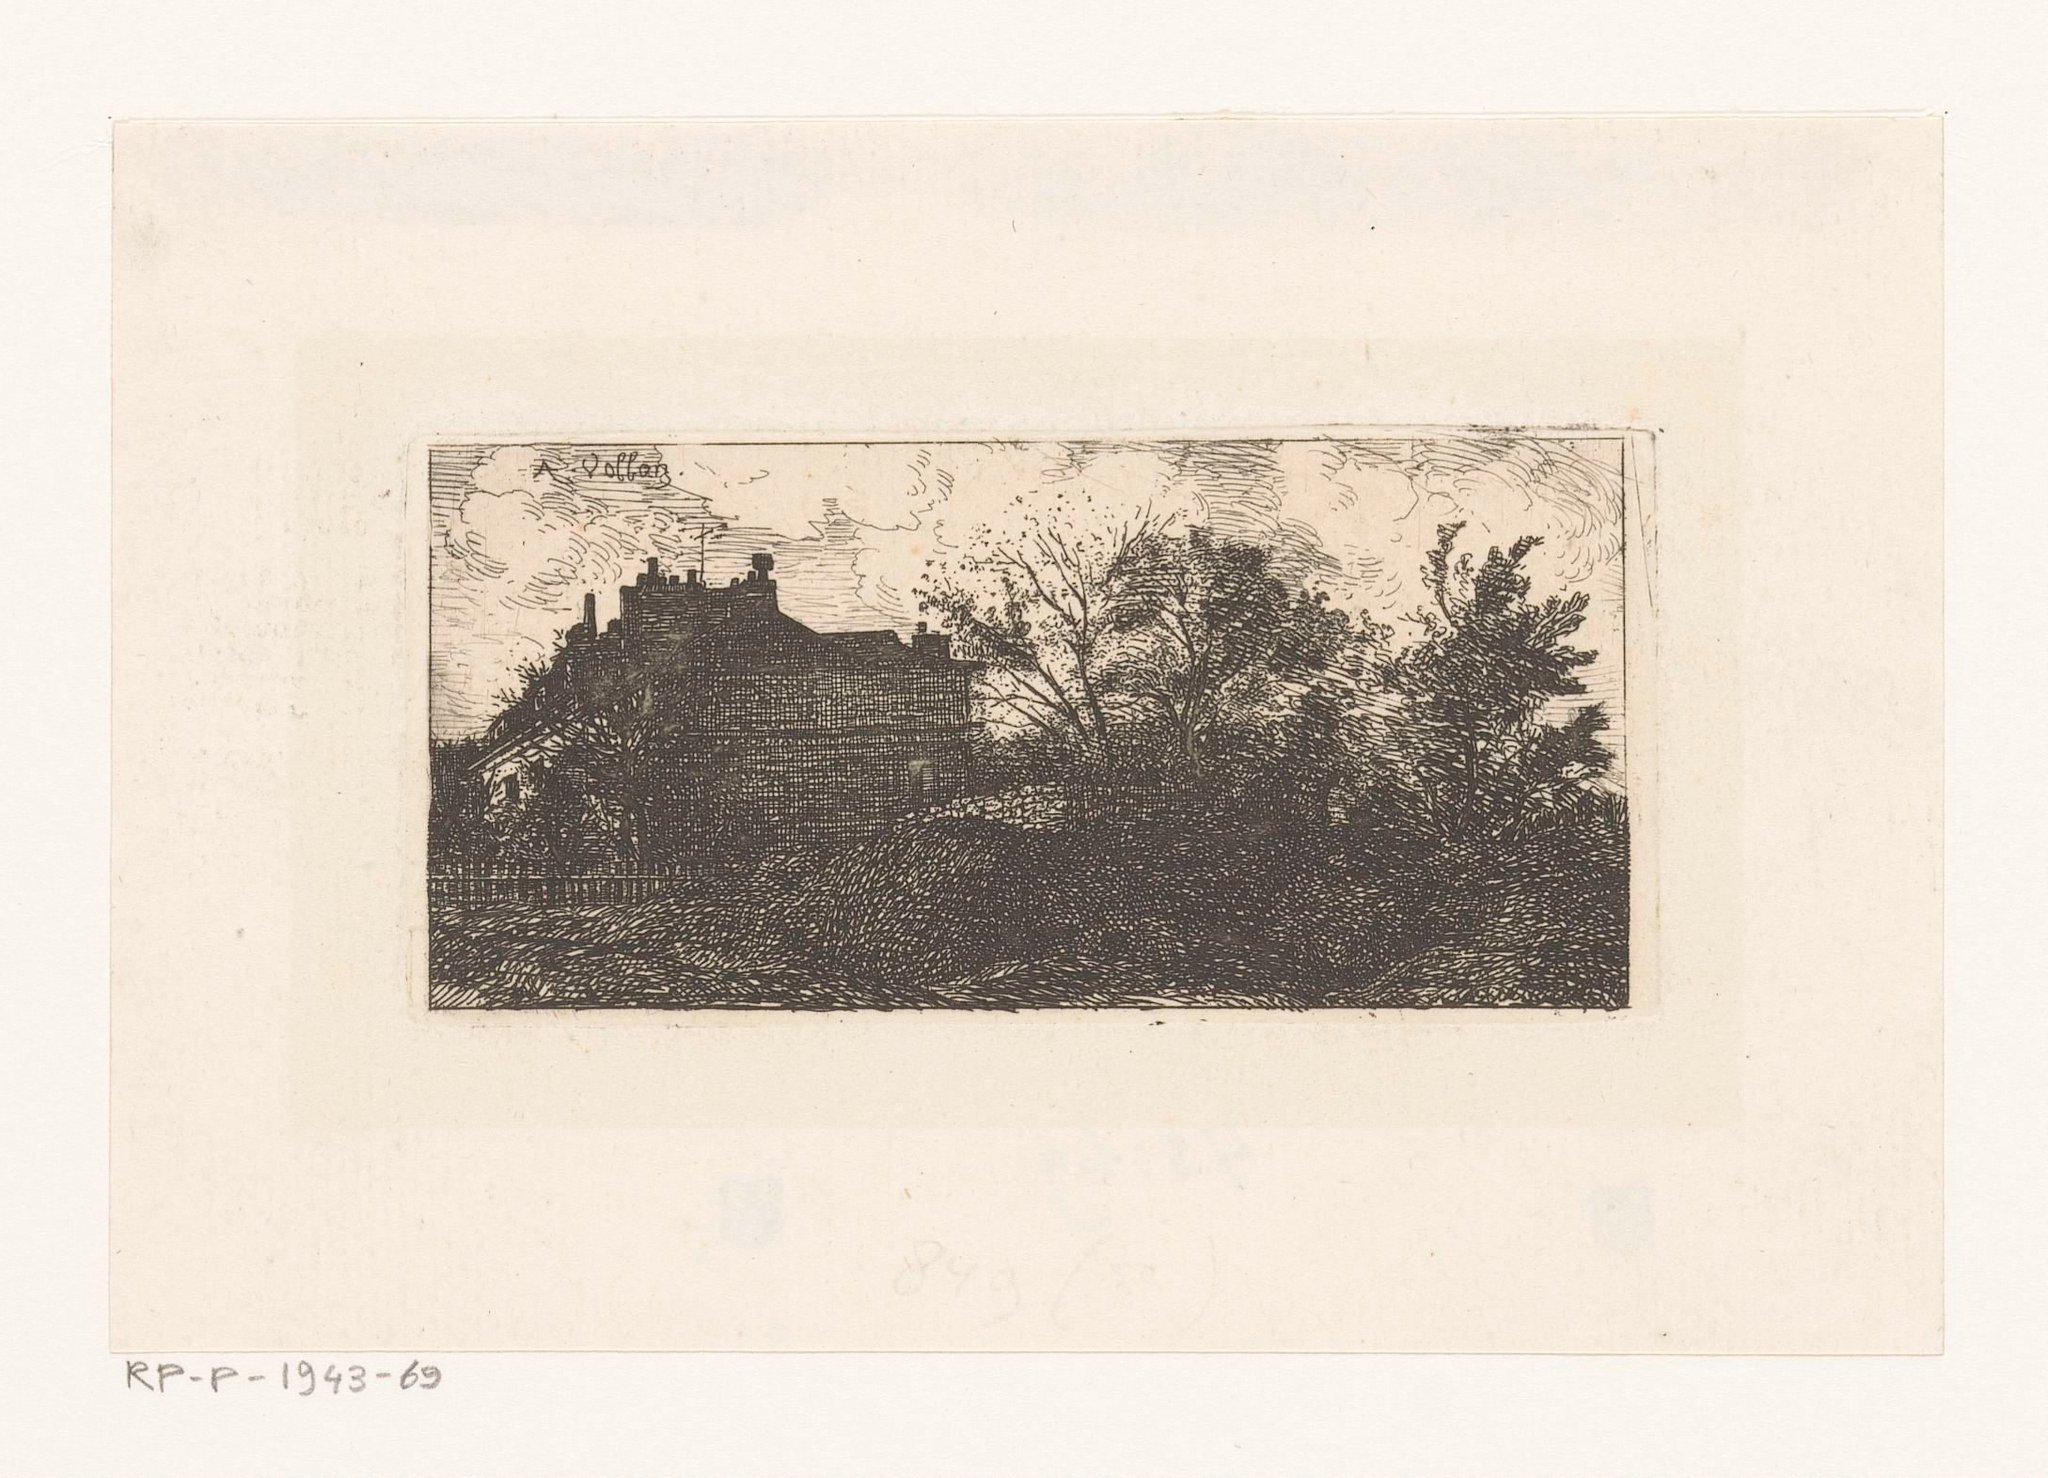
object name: print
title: Landschap met huizen achter een hek en bomen op de voorgrond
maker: antoine vollon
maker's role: painter, print maker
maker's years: 1833-1900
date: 1843-1900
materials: paper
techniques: etching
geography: france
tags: trees, landscapes, housing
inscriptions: collector's mark: Lugt 2228, collector's mark: Lugt 2760